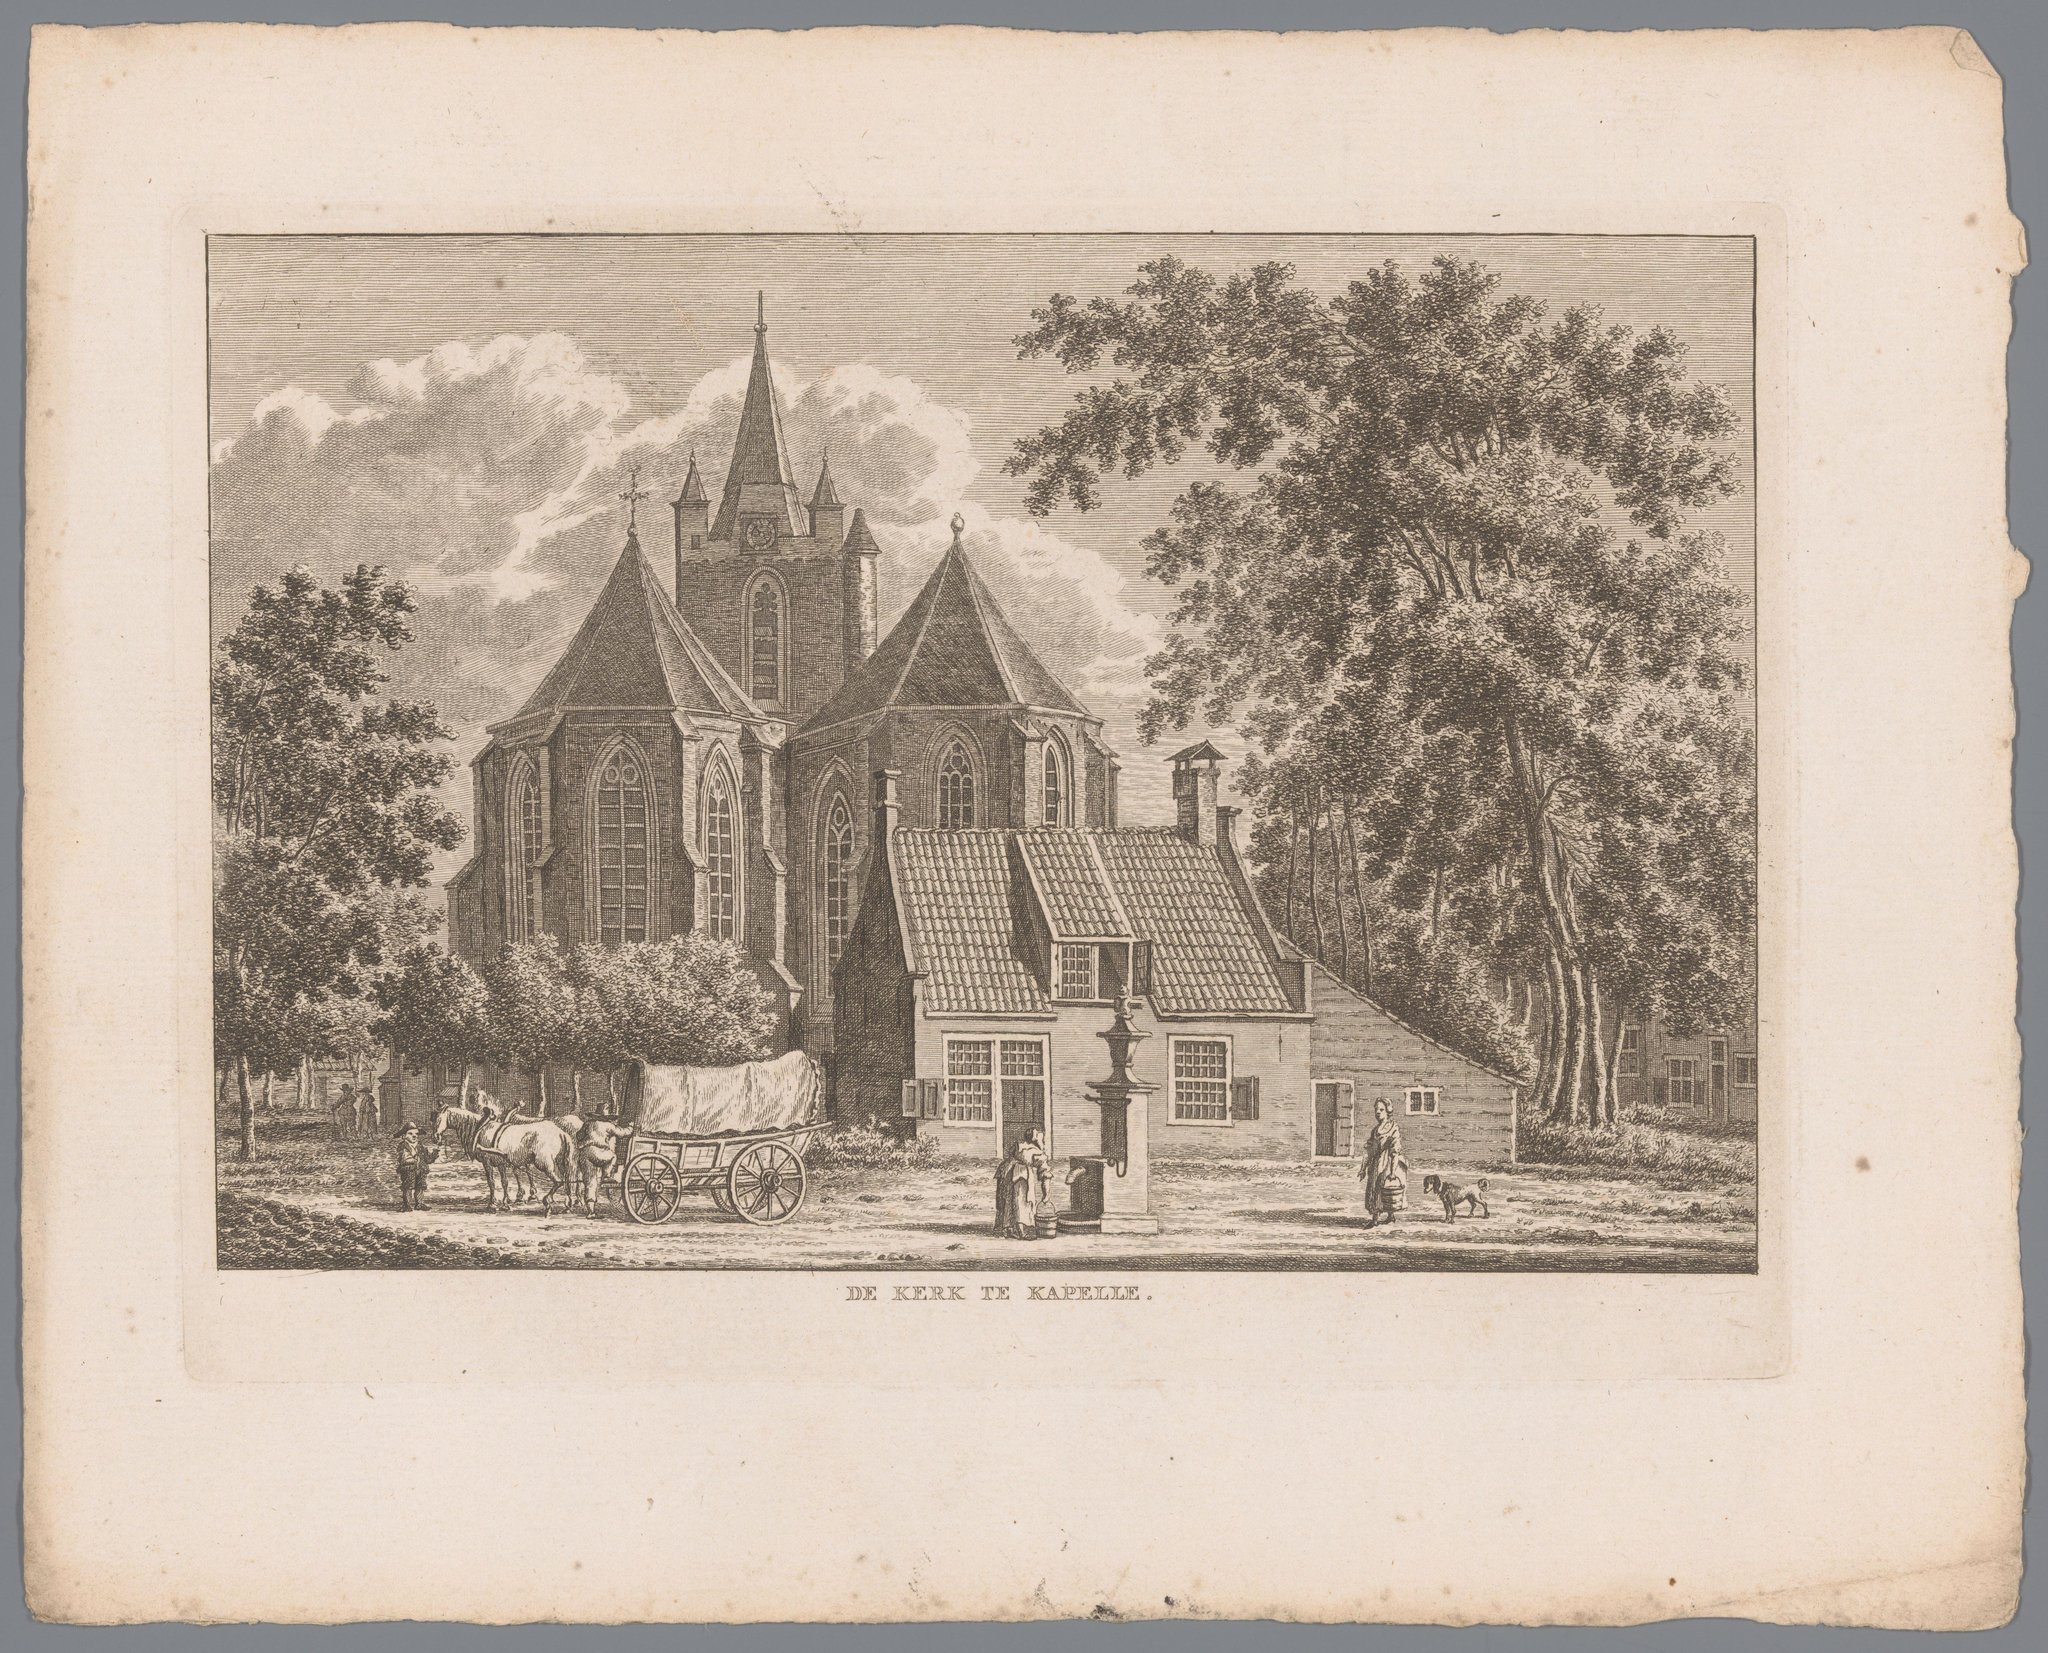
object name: print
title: Dorpsgezicht met Hervormde kerk te Kapelle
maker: carel frederik bendorp (i)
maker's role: print maker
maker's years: 1736-1814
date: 1786-1792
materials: paper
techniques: etching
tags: church (exterior)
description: Prent uit: Vaderlandsche gezichten, of afbeeldingen van den tegenwoordigen staat der Vereenigde Nederlanden (…). Amsterdam: Hendrik Gartman, Willem Vermandel en Jan Willem Smit, 1786-1792. Uitgegeven in afleveringen met ieder een eigen bifolium en inhoudsopgave. Alle prenten in deze publicatie zijn gegraveerd door Carel Frederik Bendorp (I) en, in de meeste gevallen, gebaseerd op tekeningen van Jan Bulthuis.